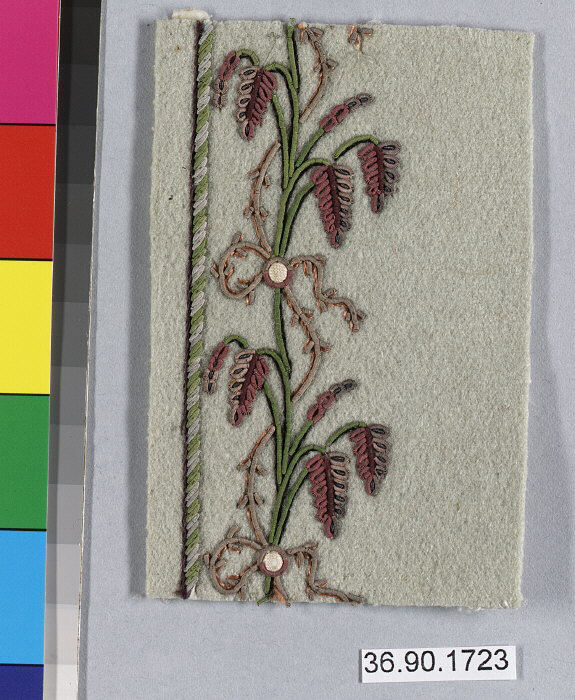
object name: sample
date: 1801-1833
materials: felt, metal thread, silk